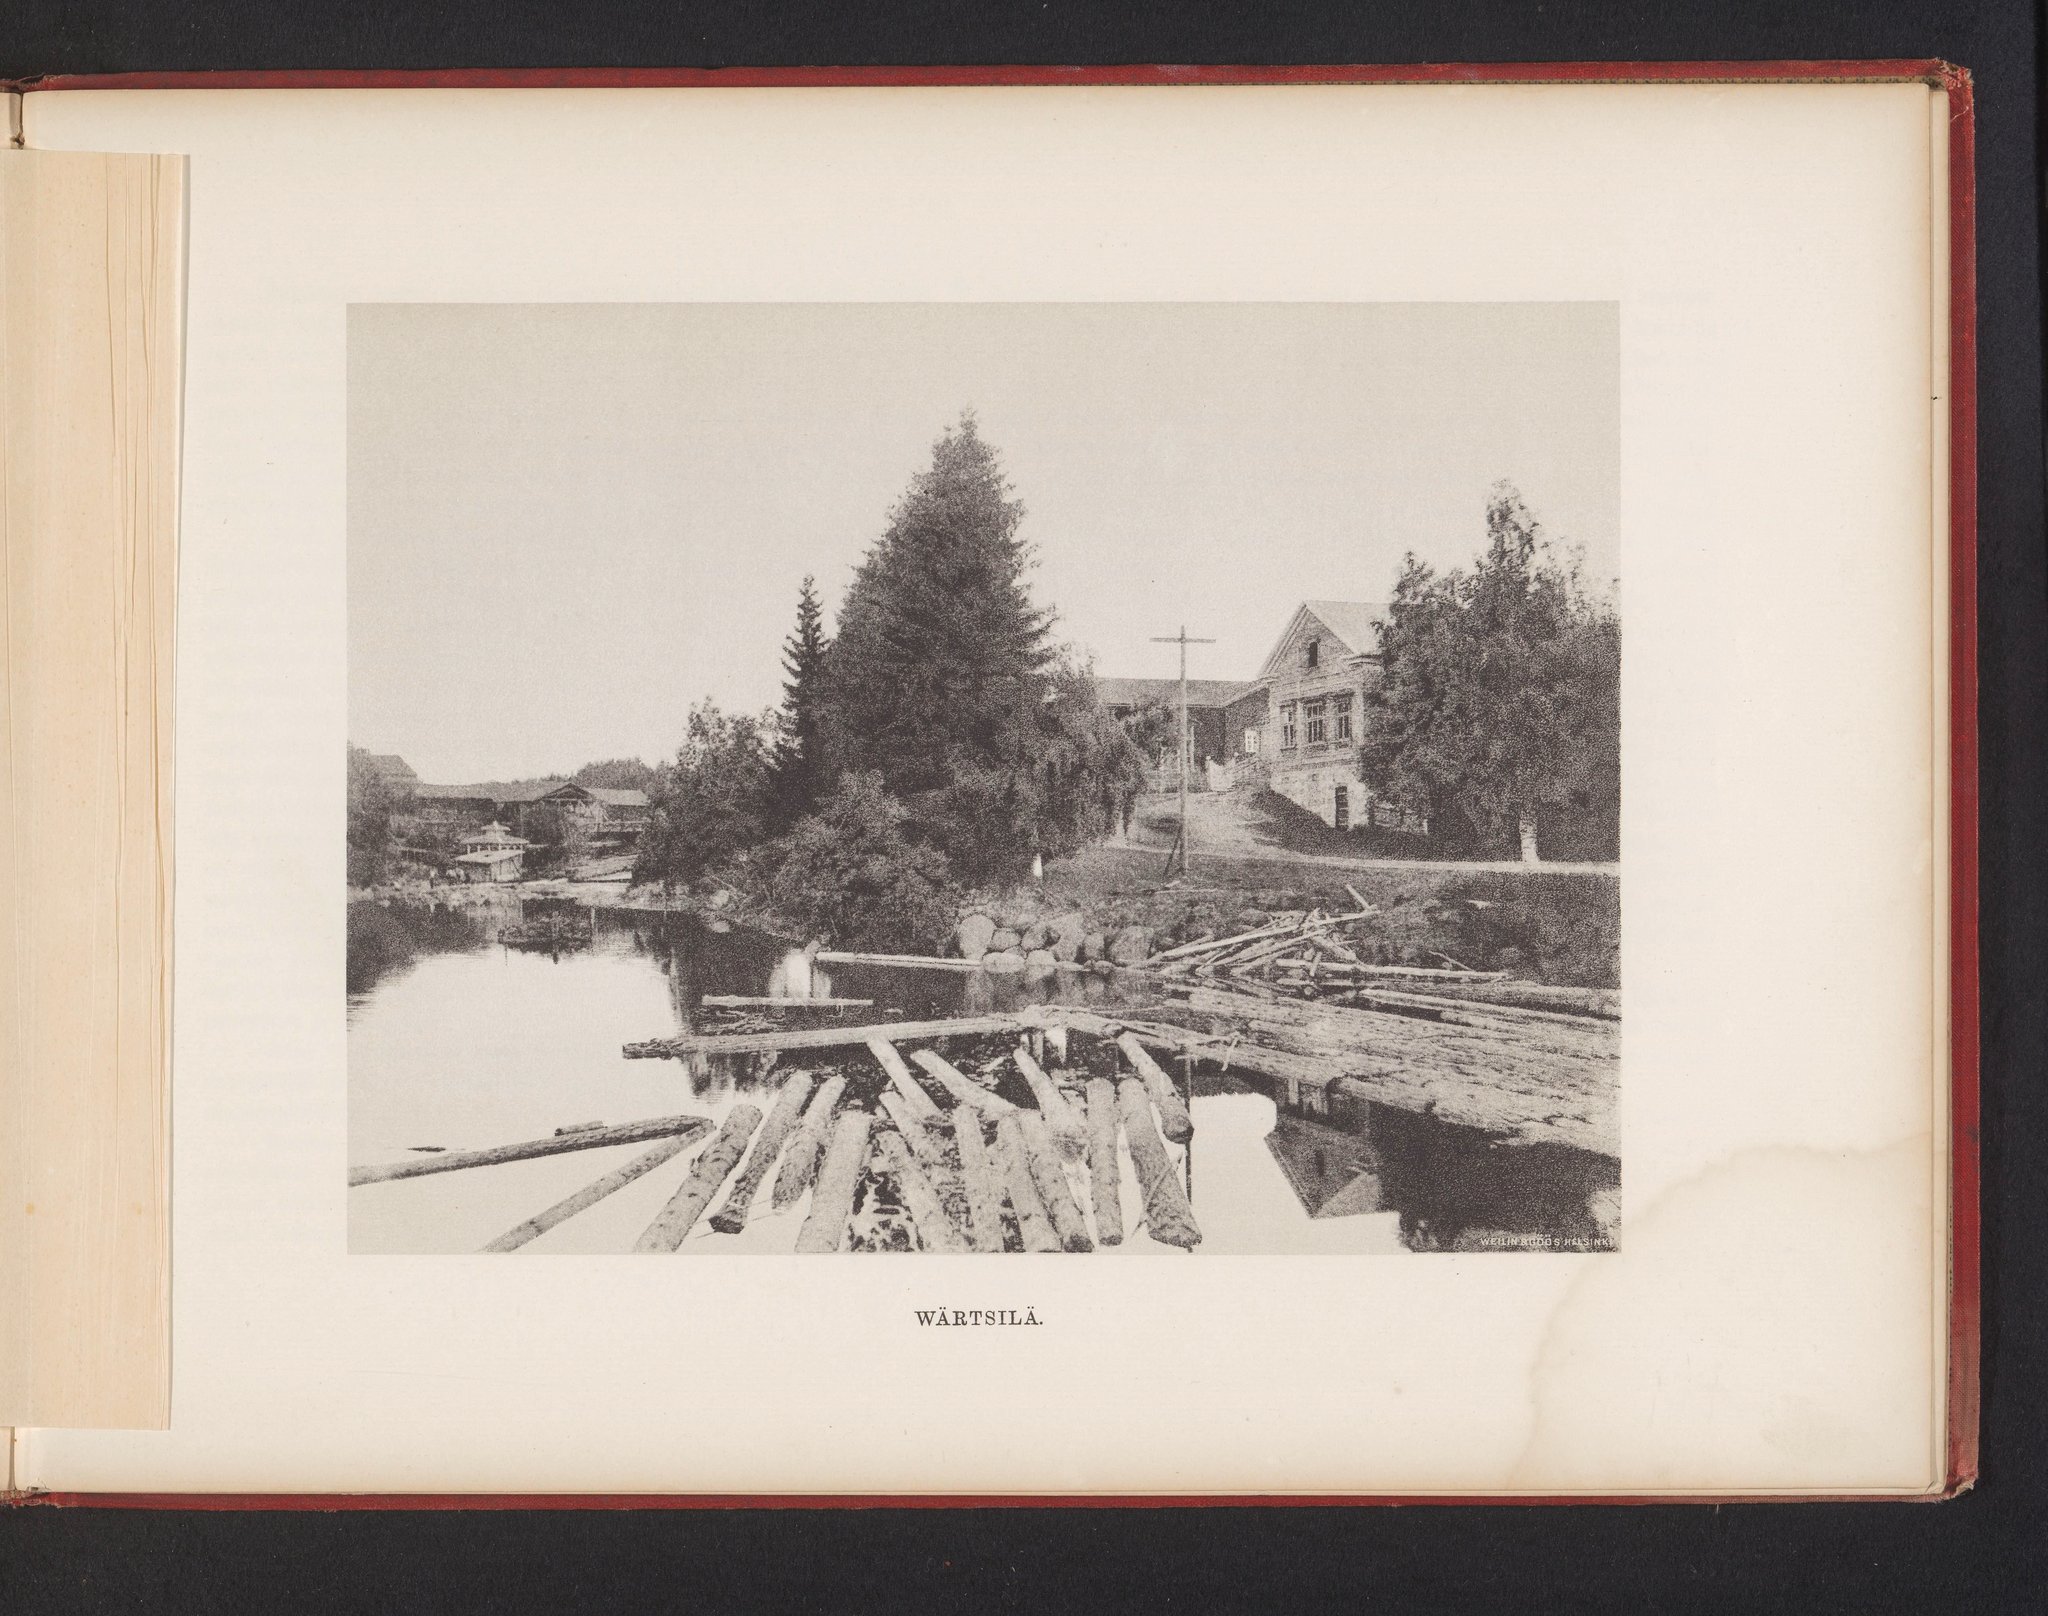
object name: photomechanical print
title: Gezicht op boomstammen in het water en huizen om het water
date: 1888-1893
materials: paper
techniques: autotype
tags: landscapes with waters, waterscapes, seascapes (in the temperate zone), civic architecture; edifices; dwellings